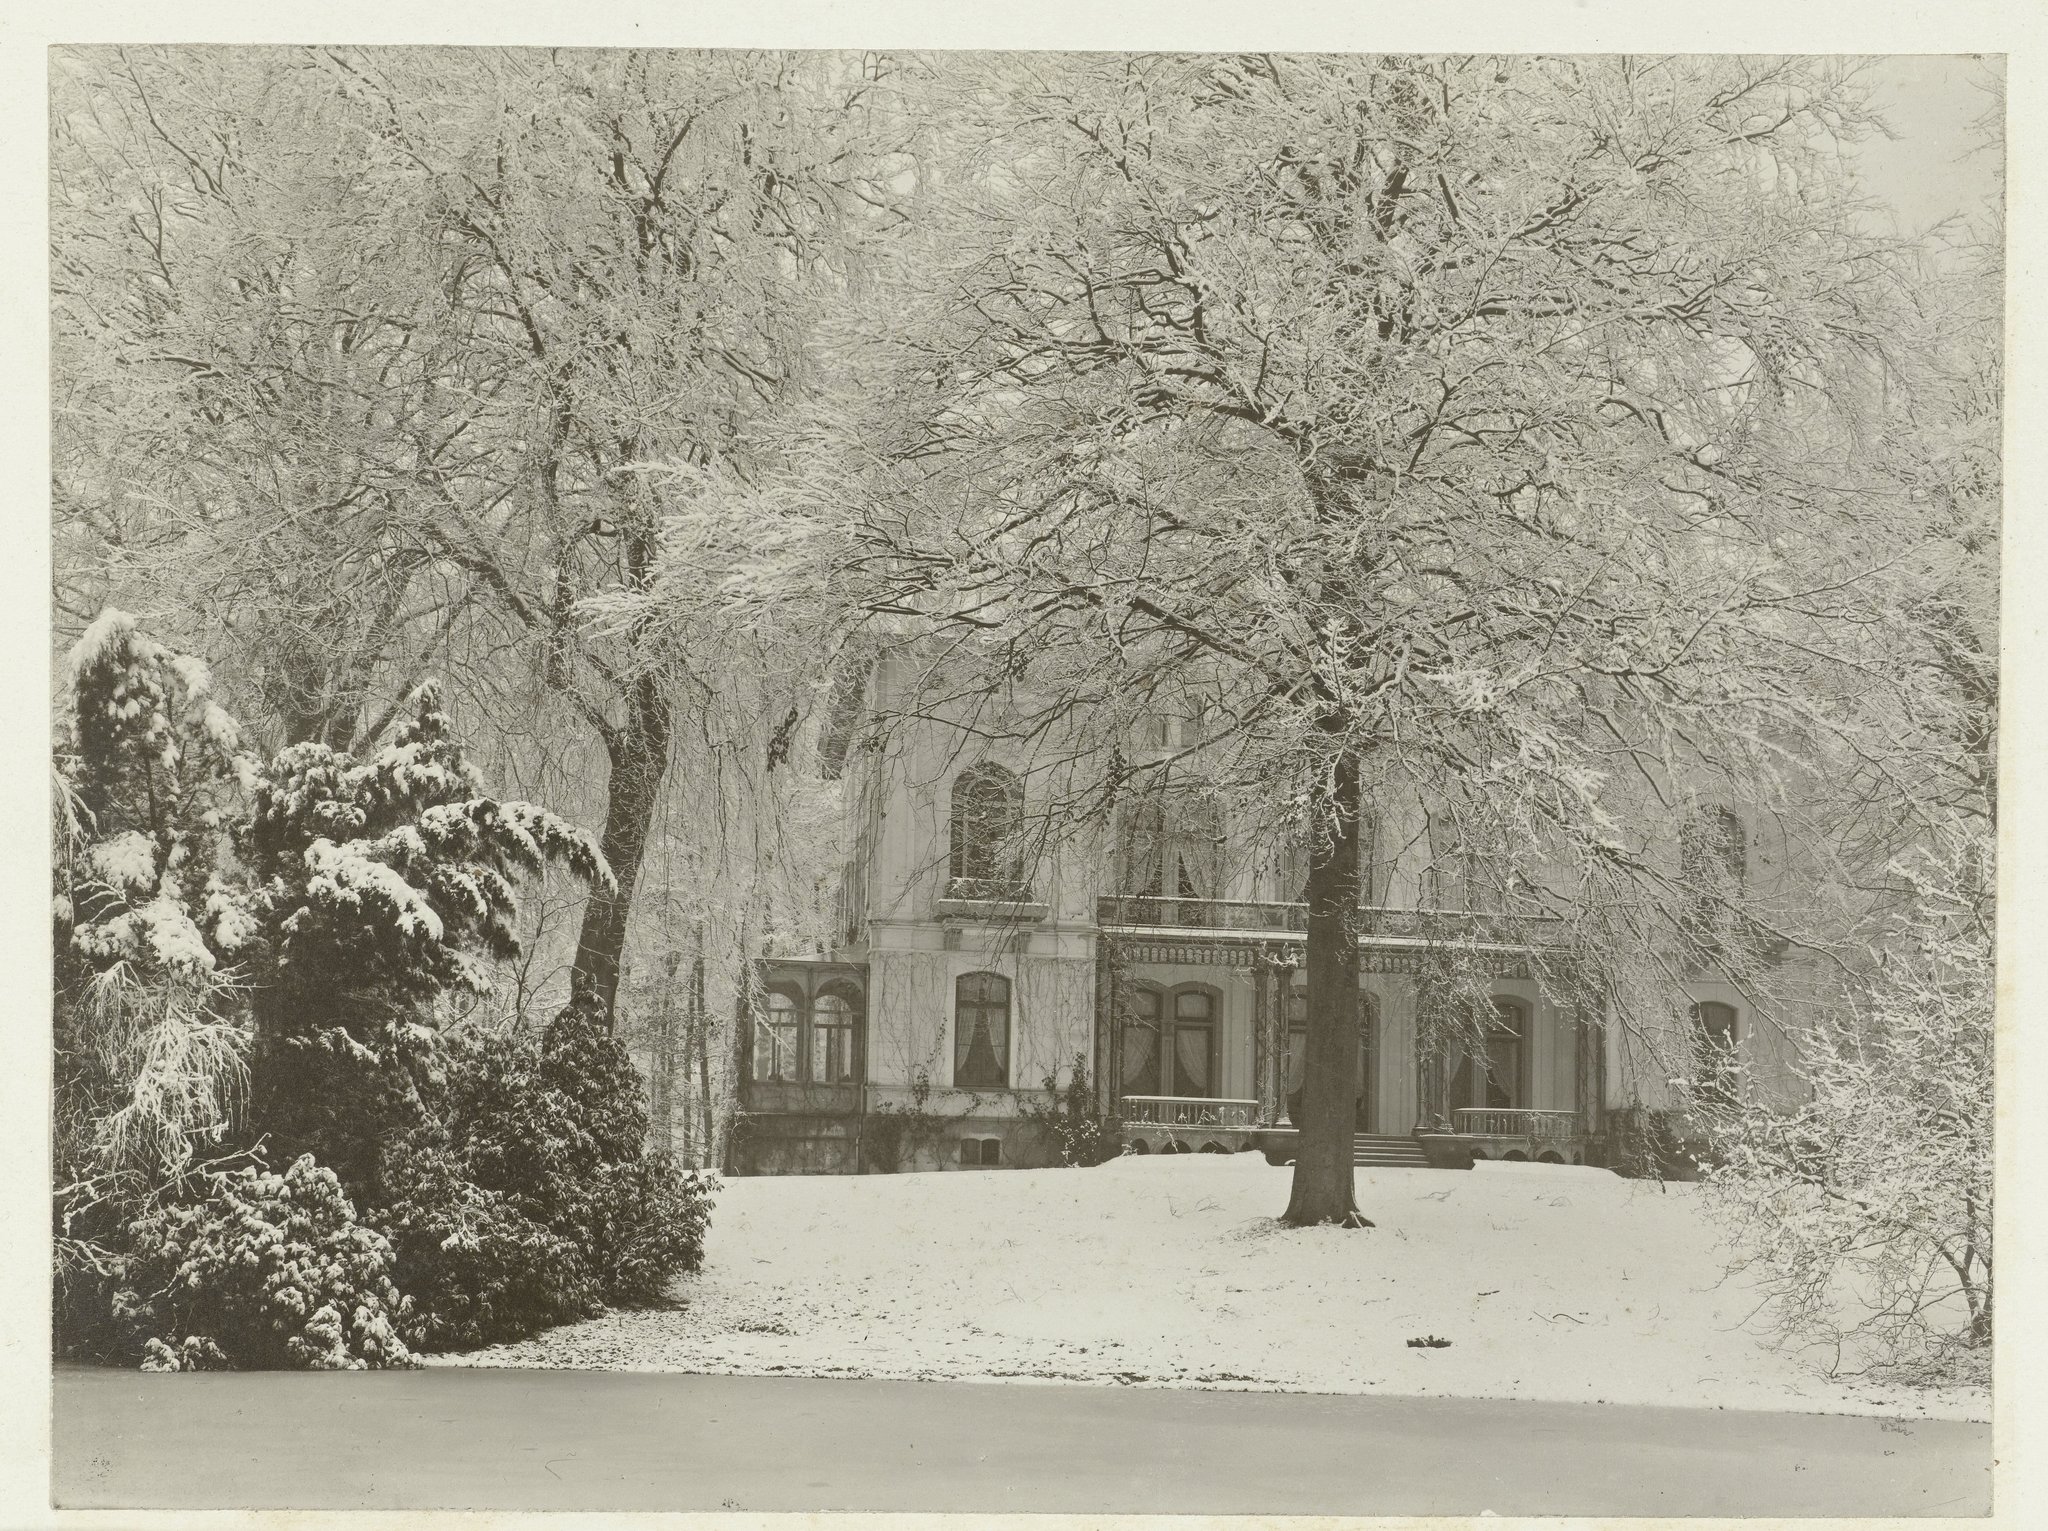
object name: photograph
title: Geziicht op landhuis De Wildbaan, Driebergen, met sneeuw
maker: henry pauw van wieldrecht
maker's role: fotograaf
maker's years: 1863-1912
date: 1903-1907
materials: paper, photographic support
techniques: gelatin silver print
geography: netherlands